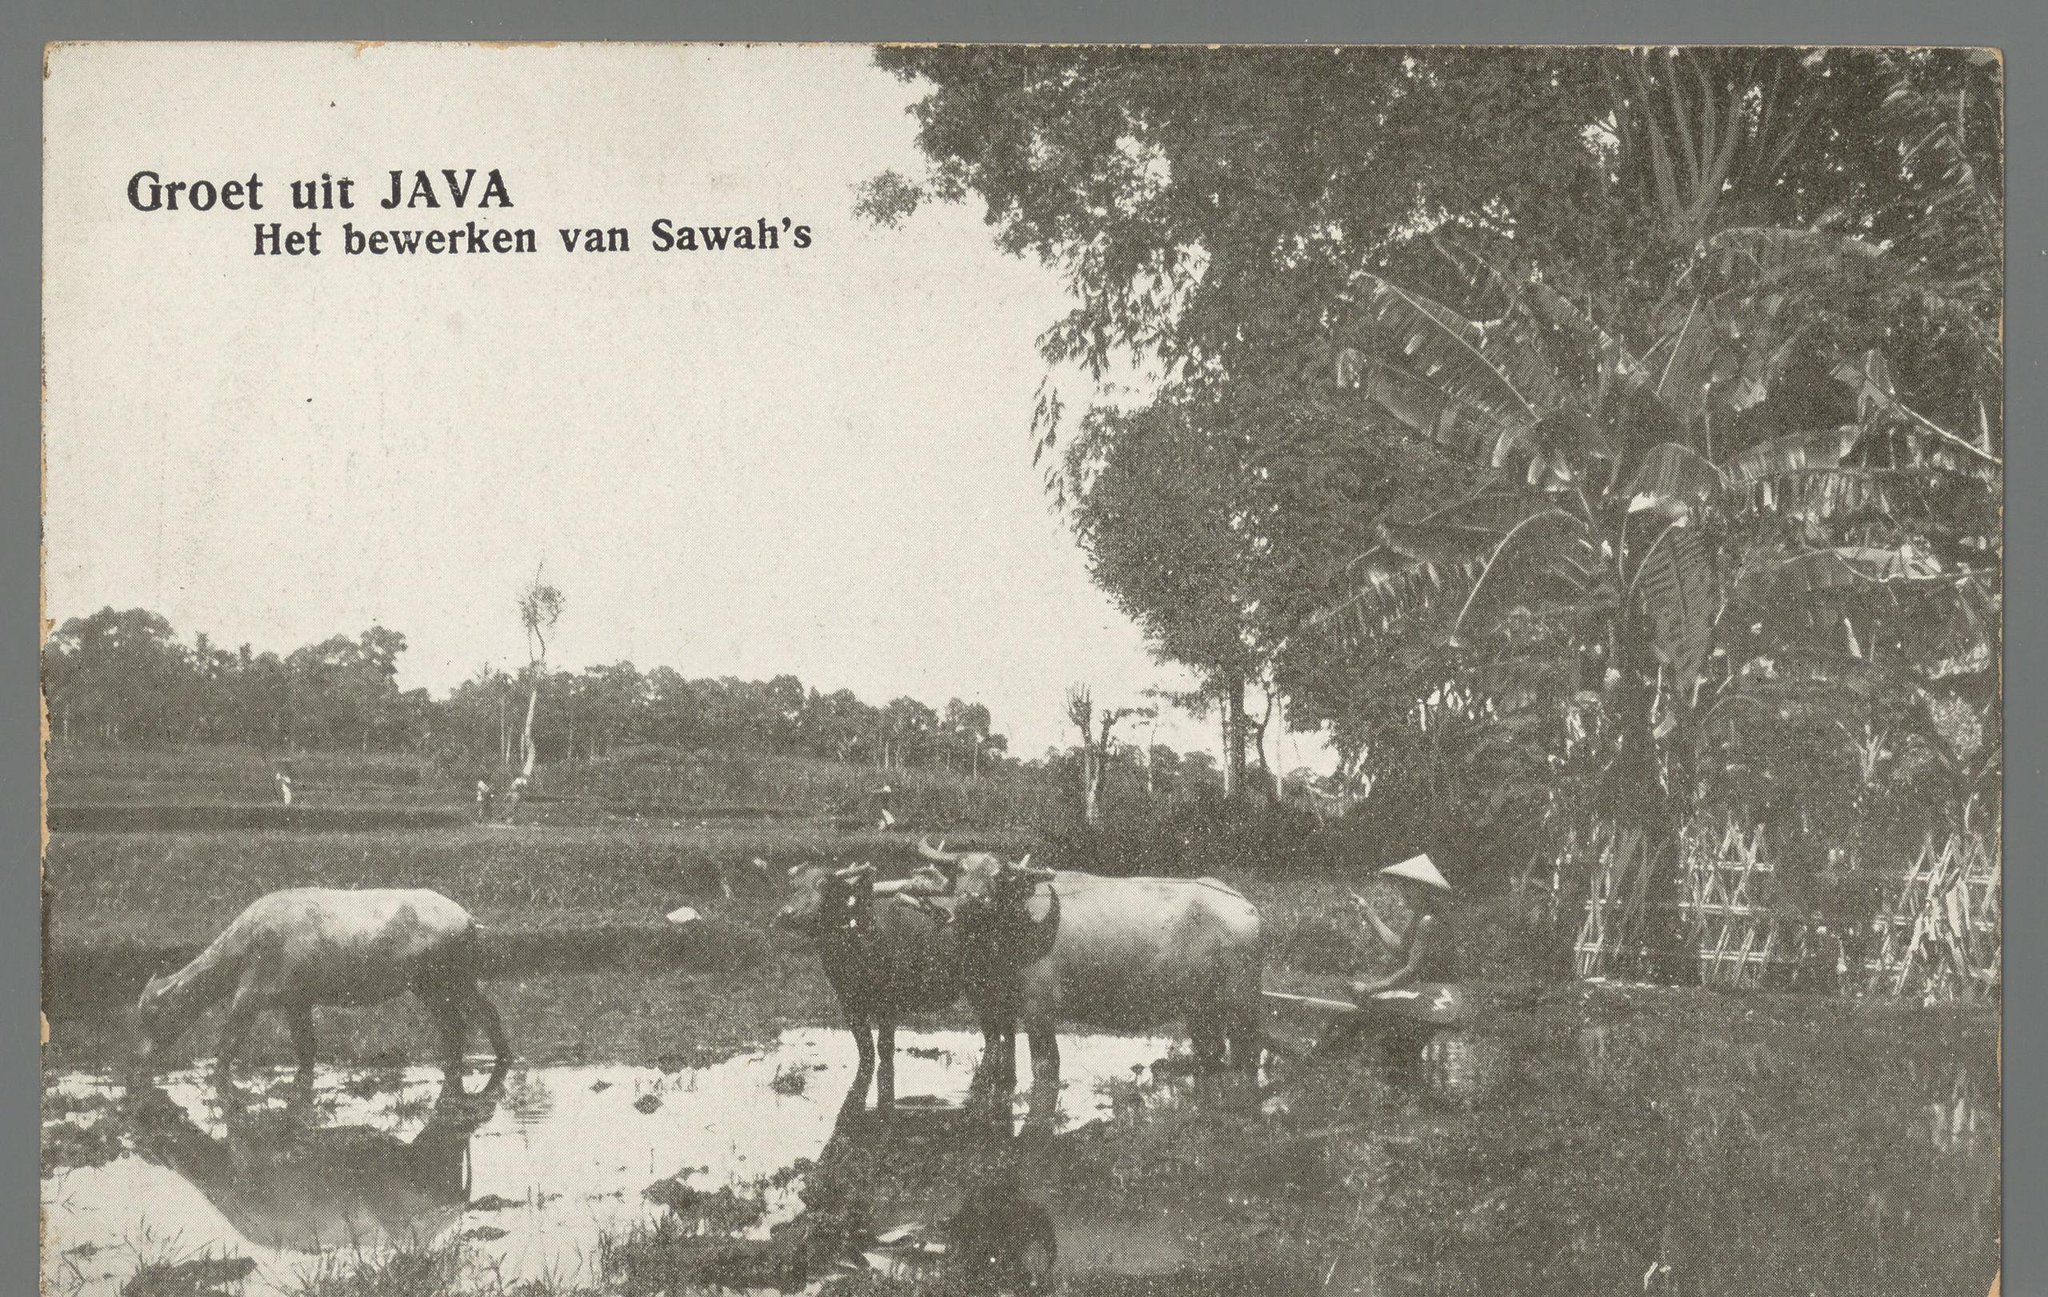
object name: photomechanical print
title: Groet uit Java. Het bewerken van sawah's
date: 1906-1930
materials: cardboard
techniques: autotype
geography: java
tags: hoofed animals: buffalo, sawahs, rice paddies, java